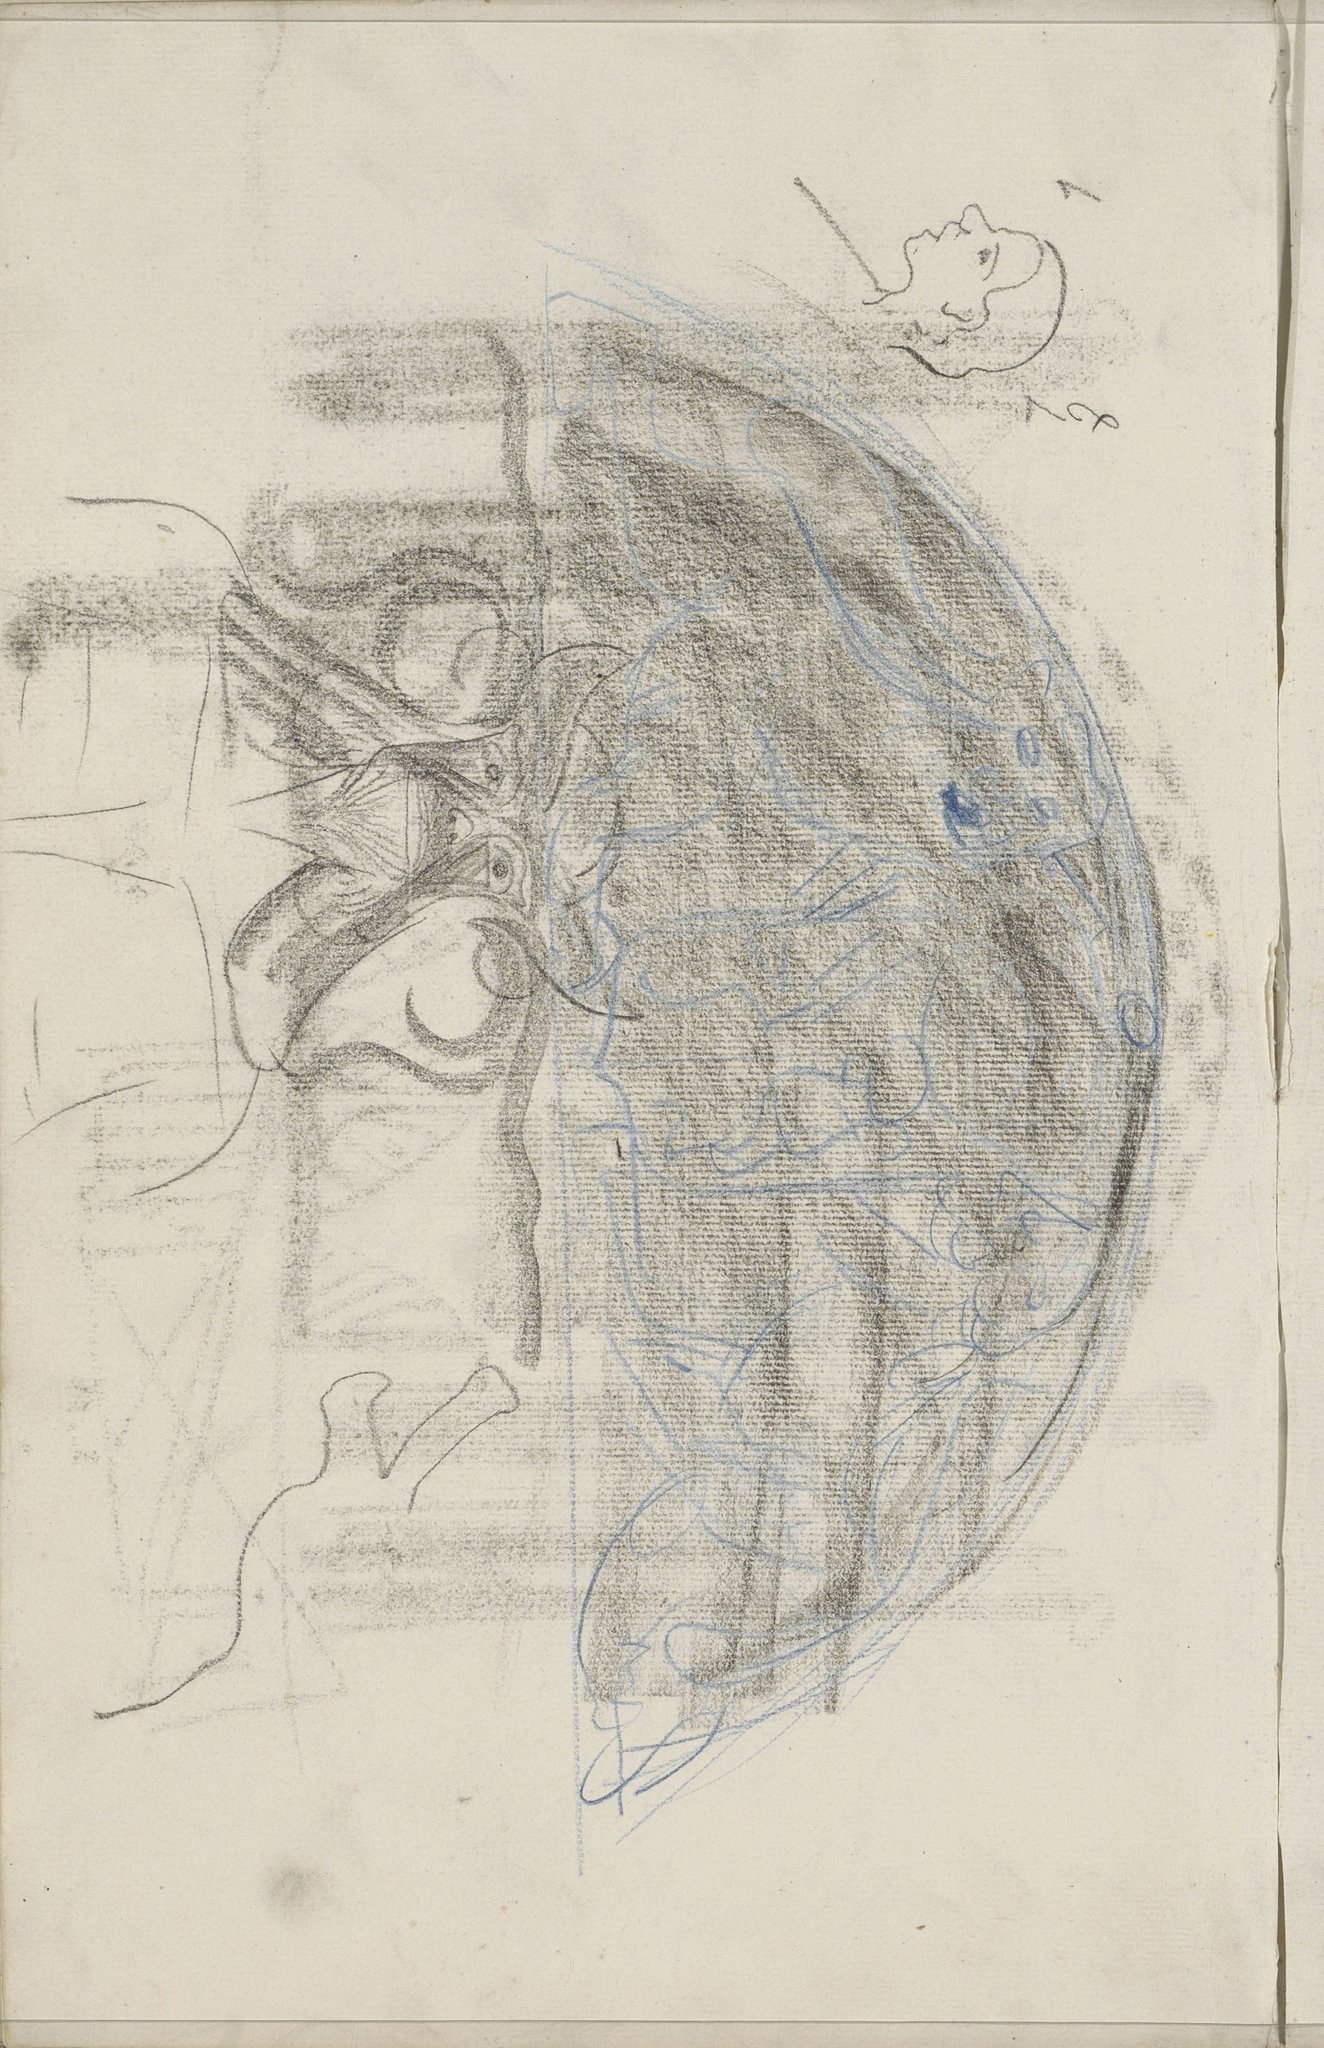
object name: sketchbook leaf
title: Fantasiefiguur, een kop en dieren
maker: carel adolph lion cachet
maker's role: draughtsman, print maker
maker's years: 1864-1945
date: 1895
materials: chalk, paper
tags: head (human), animals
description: Het fantasiefiguur heeft twee horens, een baard en halflang haar. Blad 14 verso uit een schetsboek met 23 bladen.